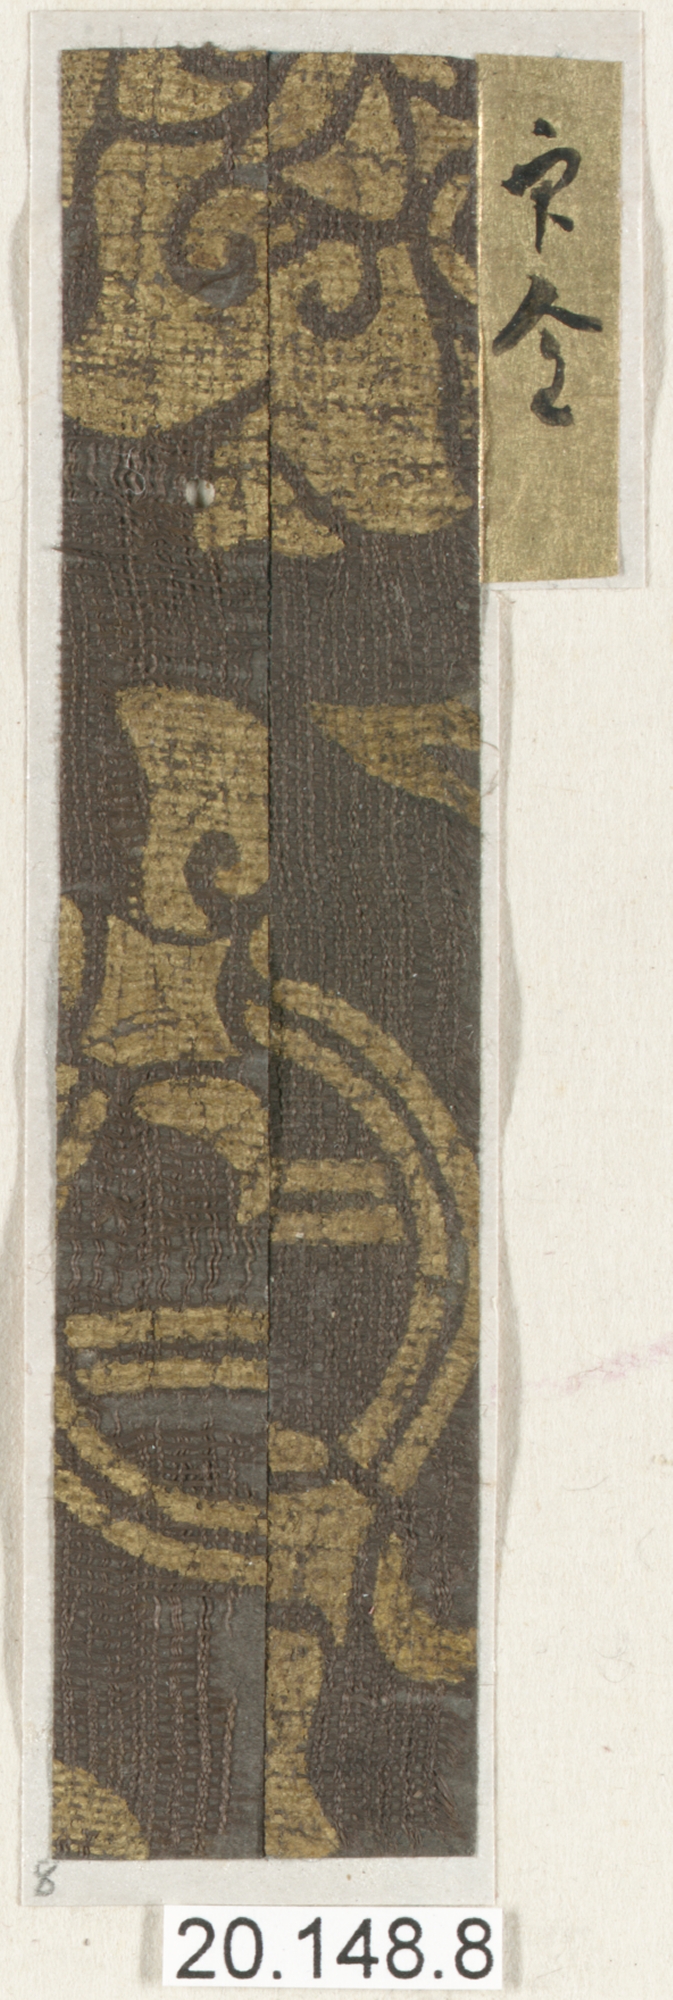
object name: piece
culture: japanese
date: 901-1000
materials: silk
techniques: compound weave